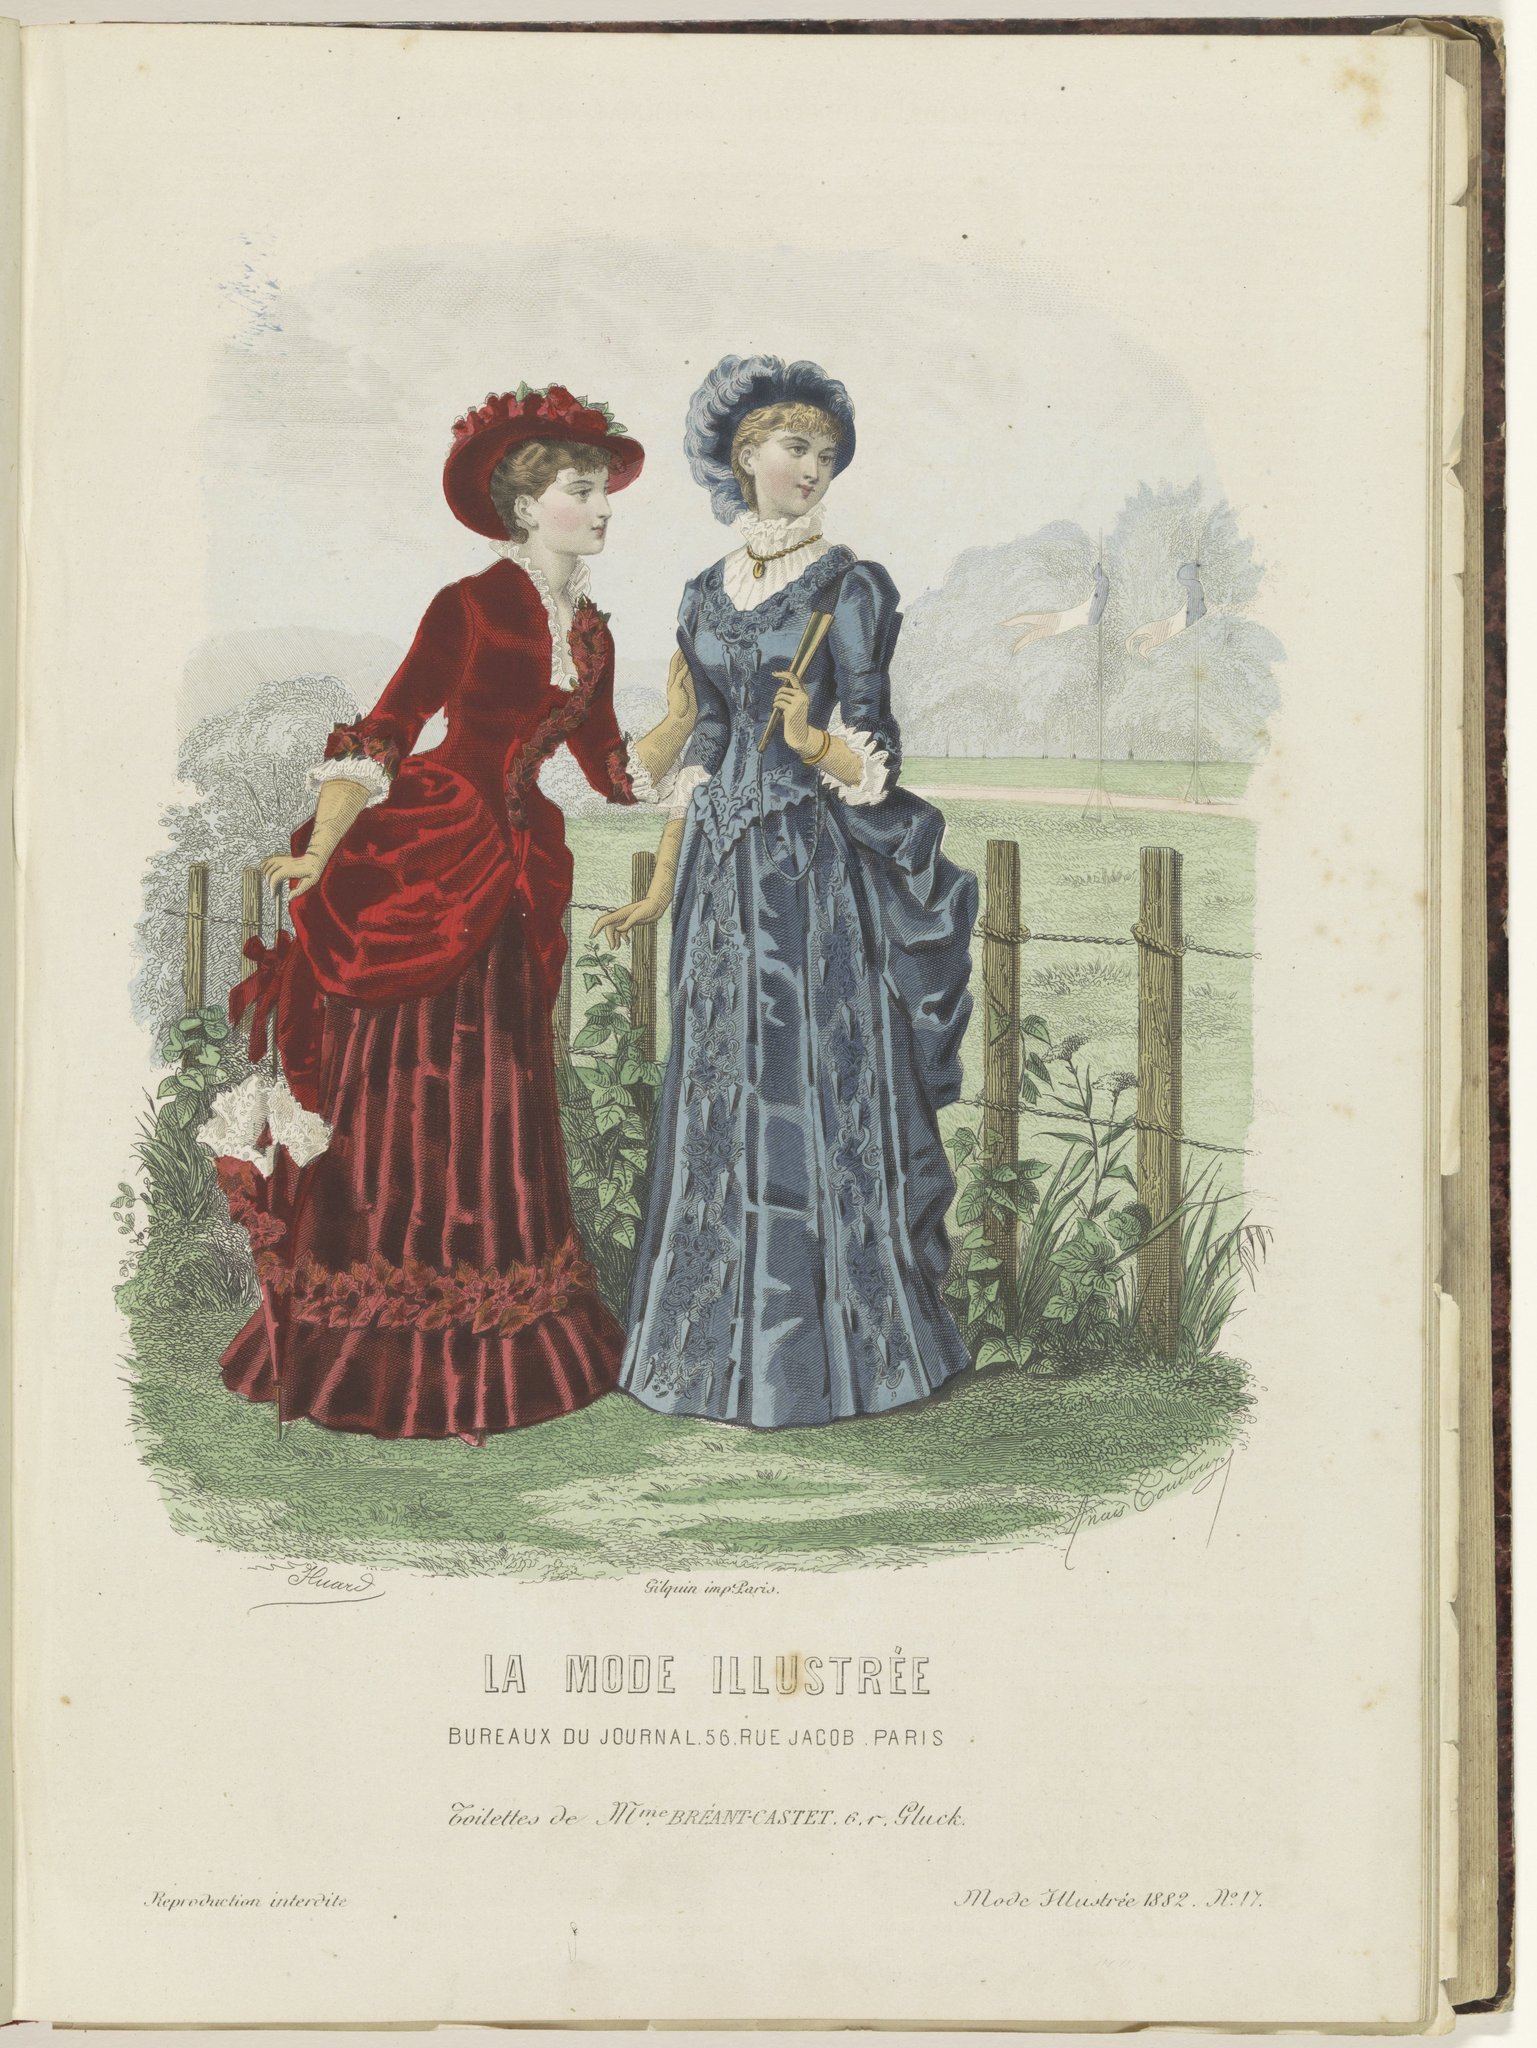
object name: magazine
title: La Mode Illustrée, Journal de la Famille, 1882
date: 1882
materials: paper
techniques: engraving, hand coloring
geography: paris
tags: fashion plates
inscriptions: date